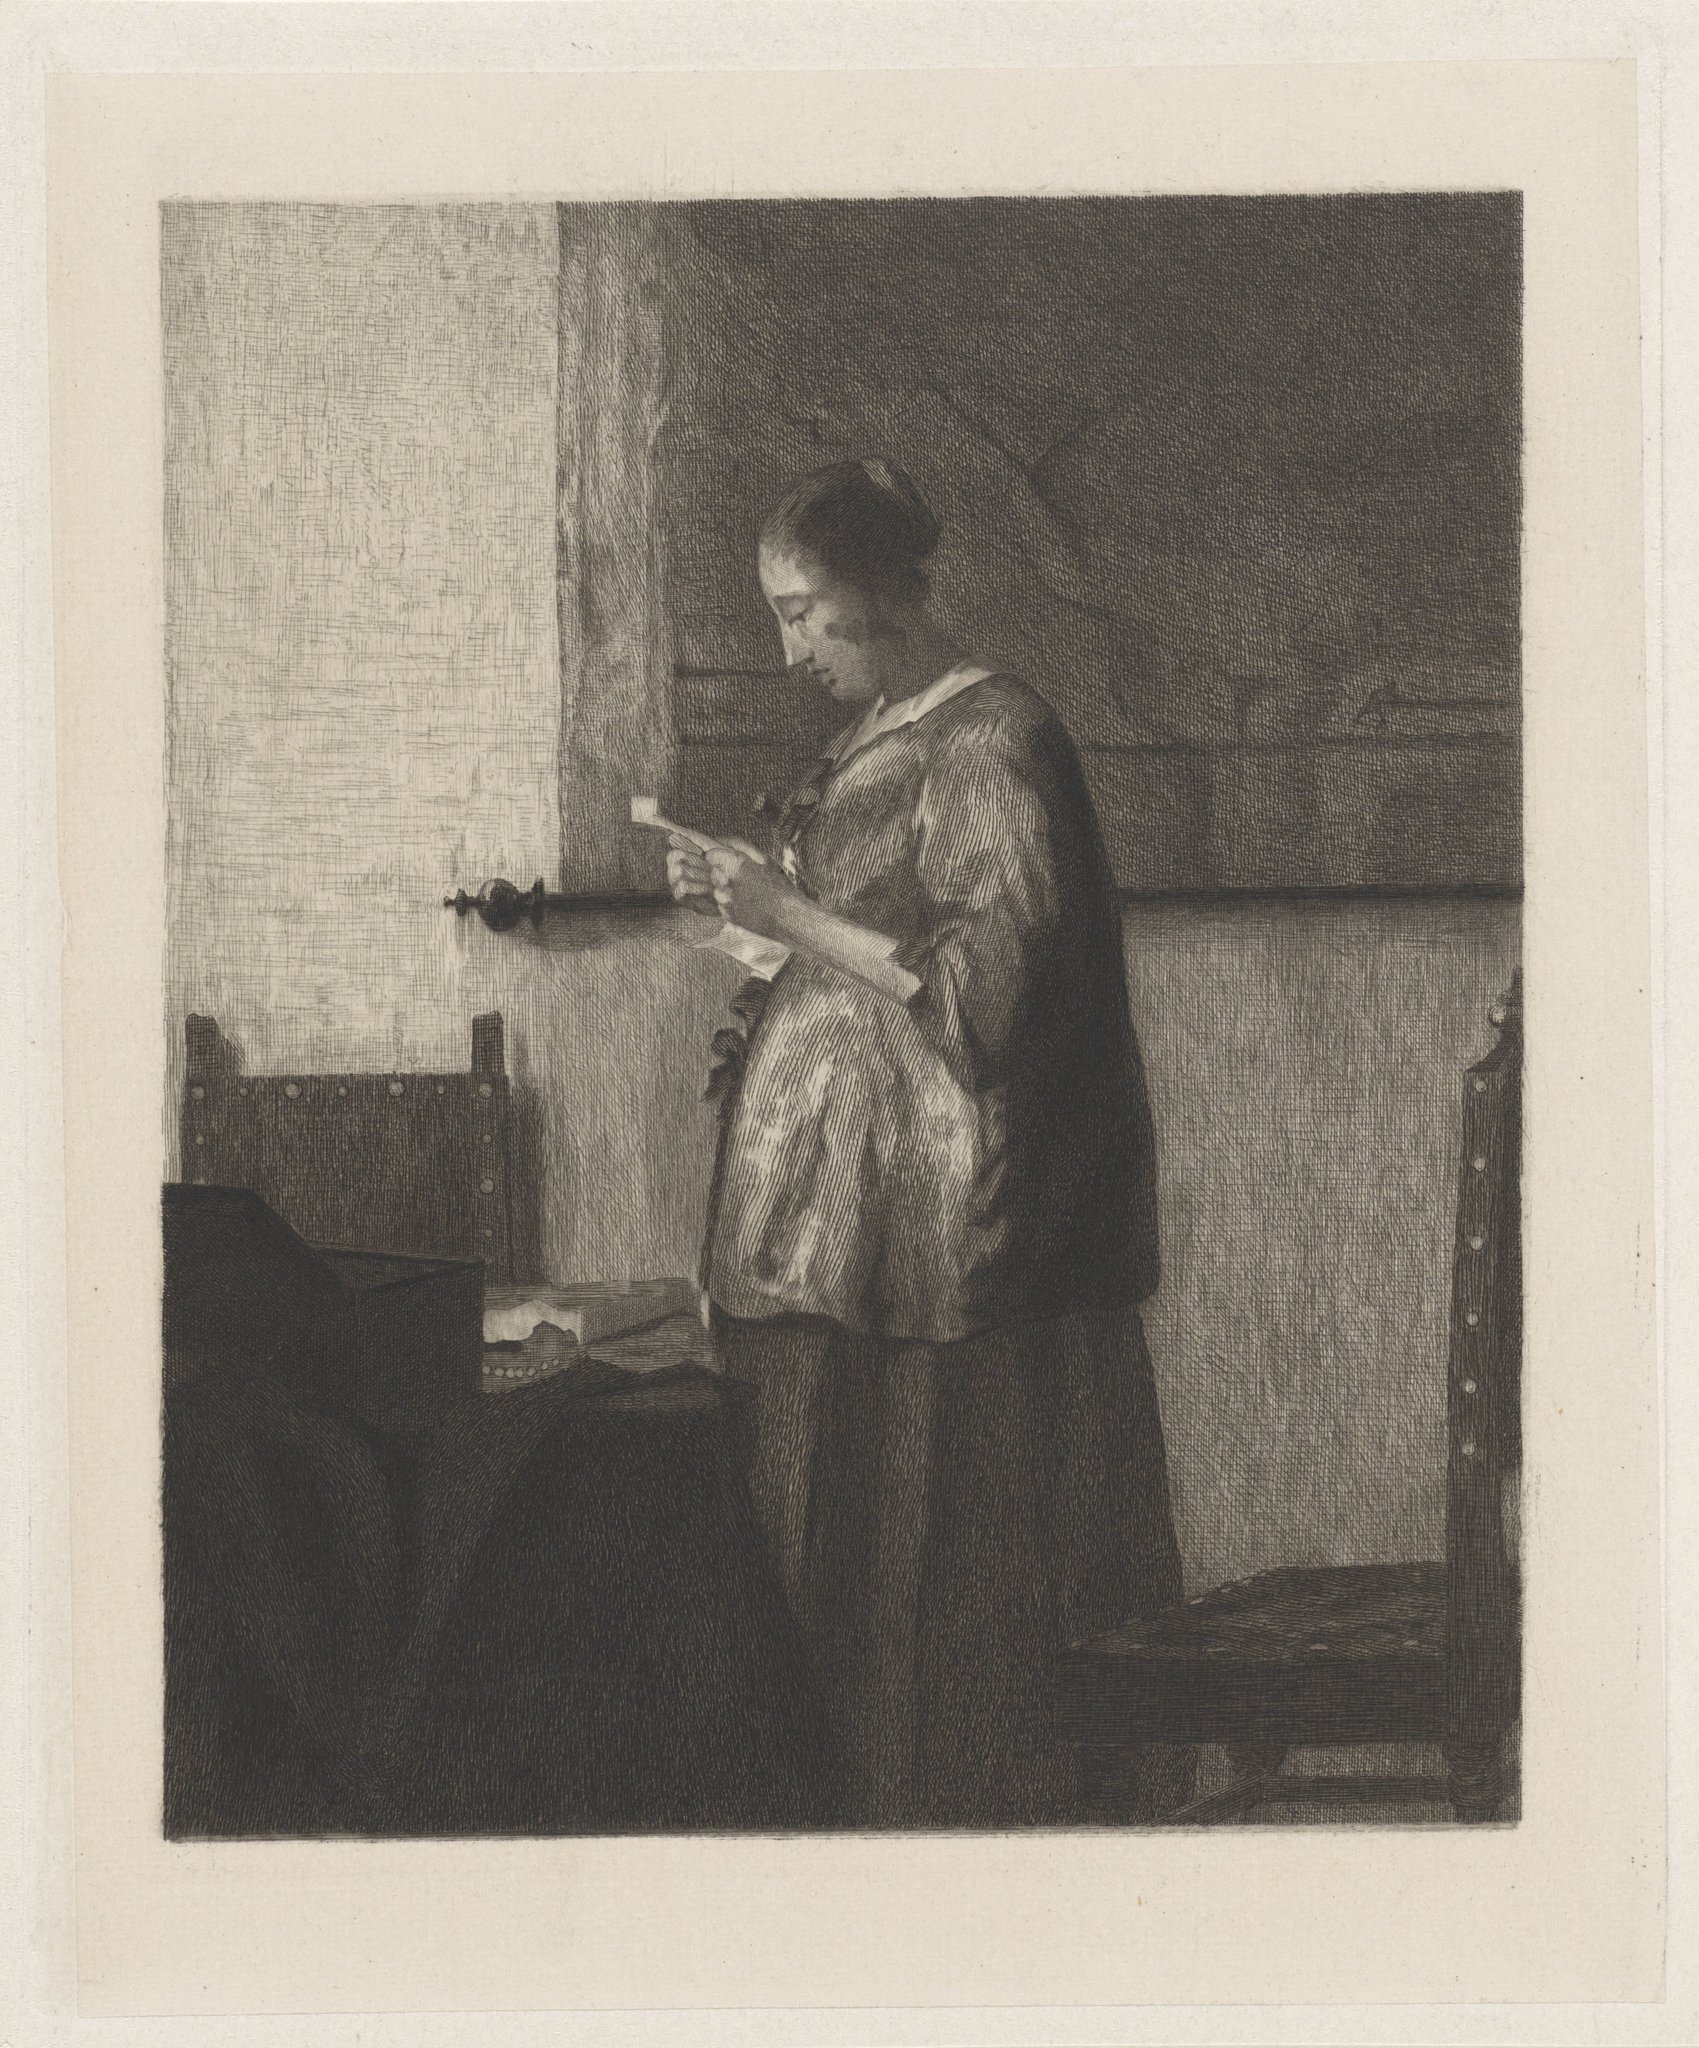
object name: print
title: Brieflezende vrouw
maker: willem steelink (i)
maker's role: draughtsman, print maker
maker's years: 1826-1913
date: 1866-1890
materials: paper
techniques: engraving, etching, intaglio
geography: netherlands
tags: reading, maps, atlases, letter, envelope, chair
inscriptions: collector's mark: Lugt 2228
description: Brieflezende vrouw. Een jonge vrouw, staande bij een tafel met stoelen, leest een brief. Achter haar hangt aan de muur een landkaart op rollen.